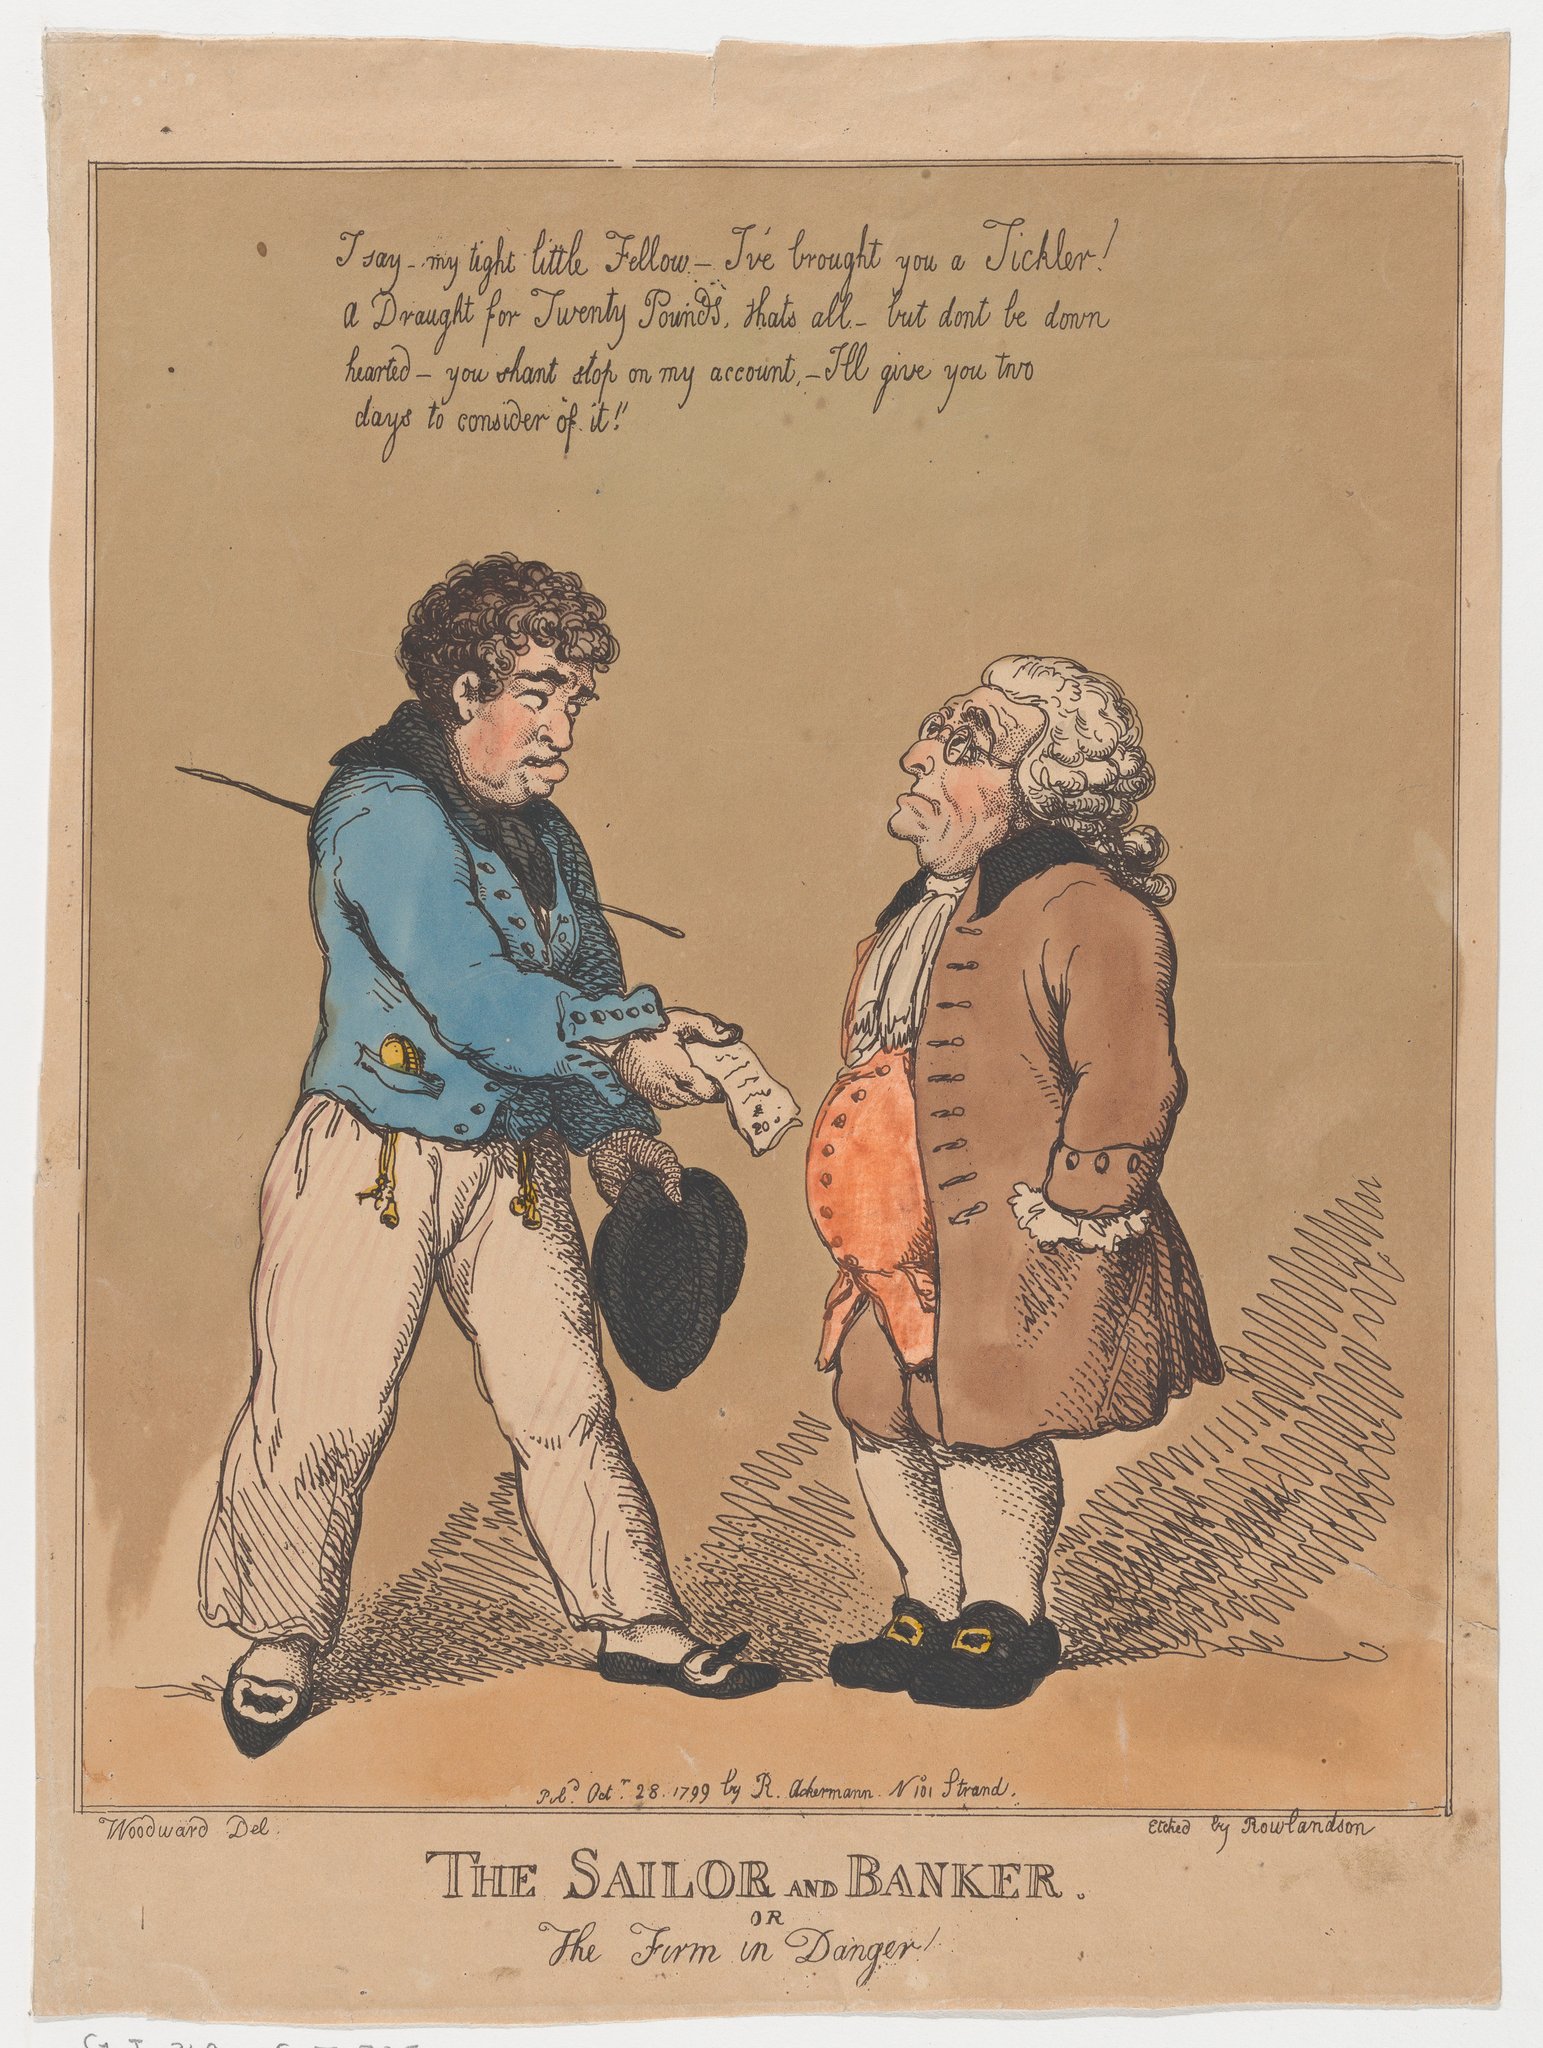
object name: print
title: The Sailor and Banker, or the Firm in Danger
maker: thomas rowlandson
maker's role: artist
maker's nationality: british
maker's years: 1757-1827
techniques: etching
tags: satire,men